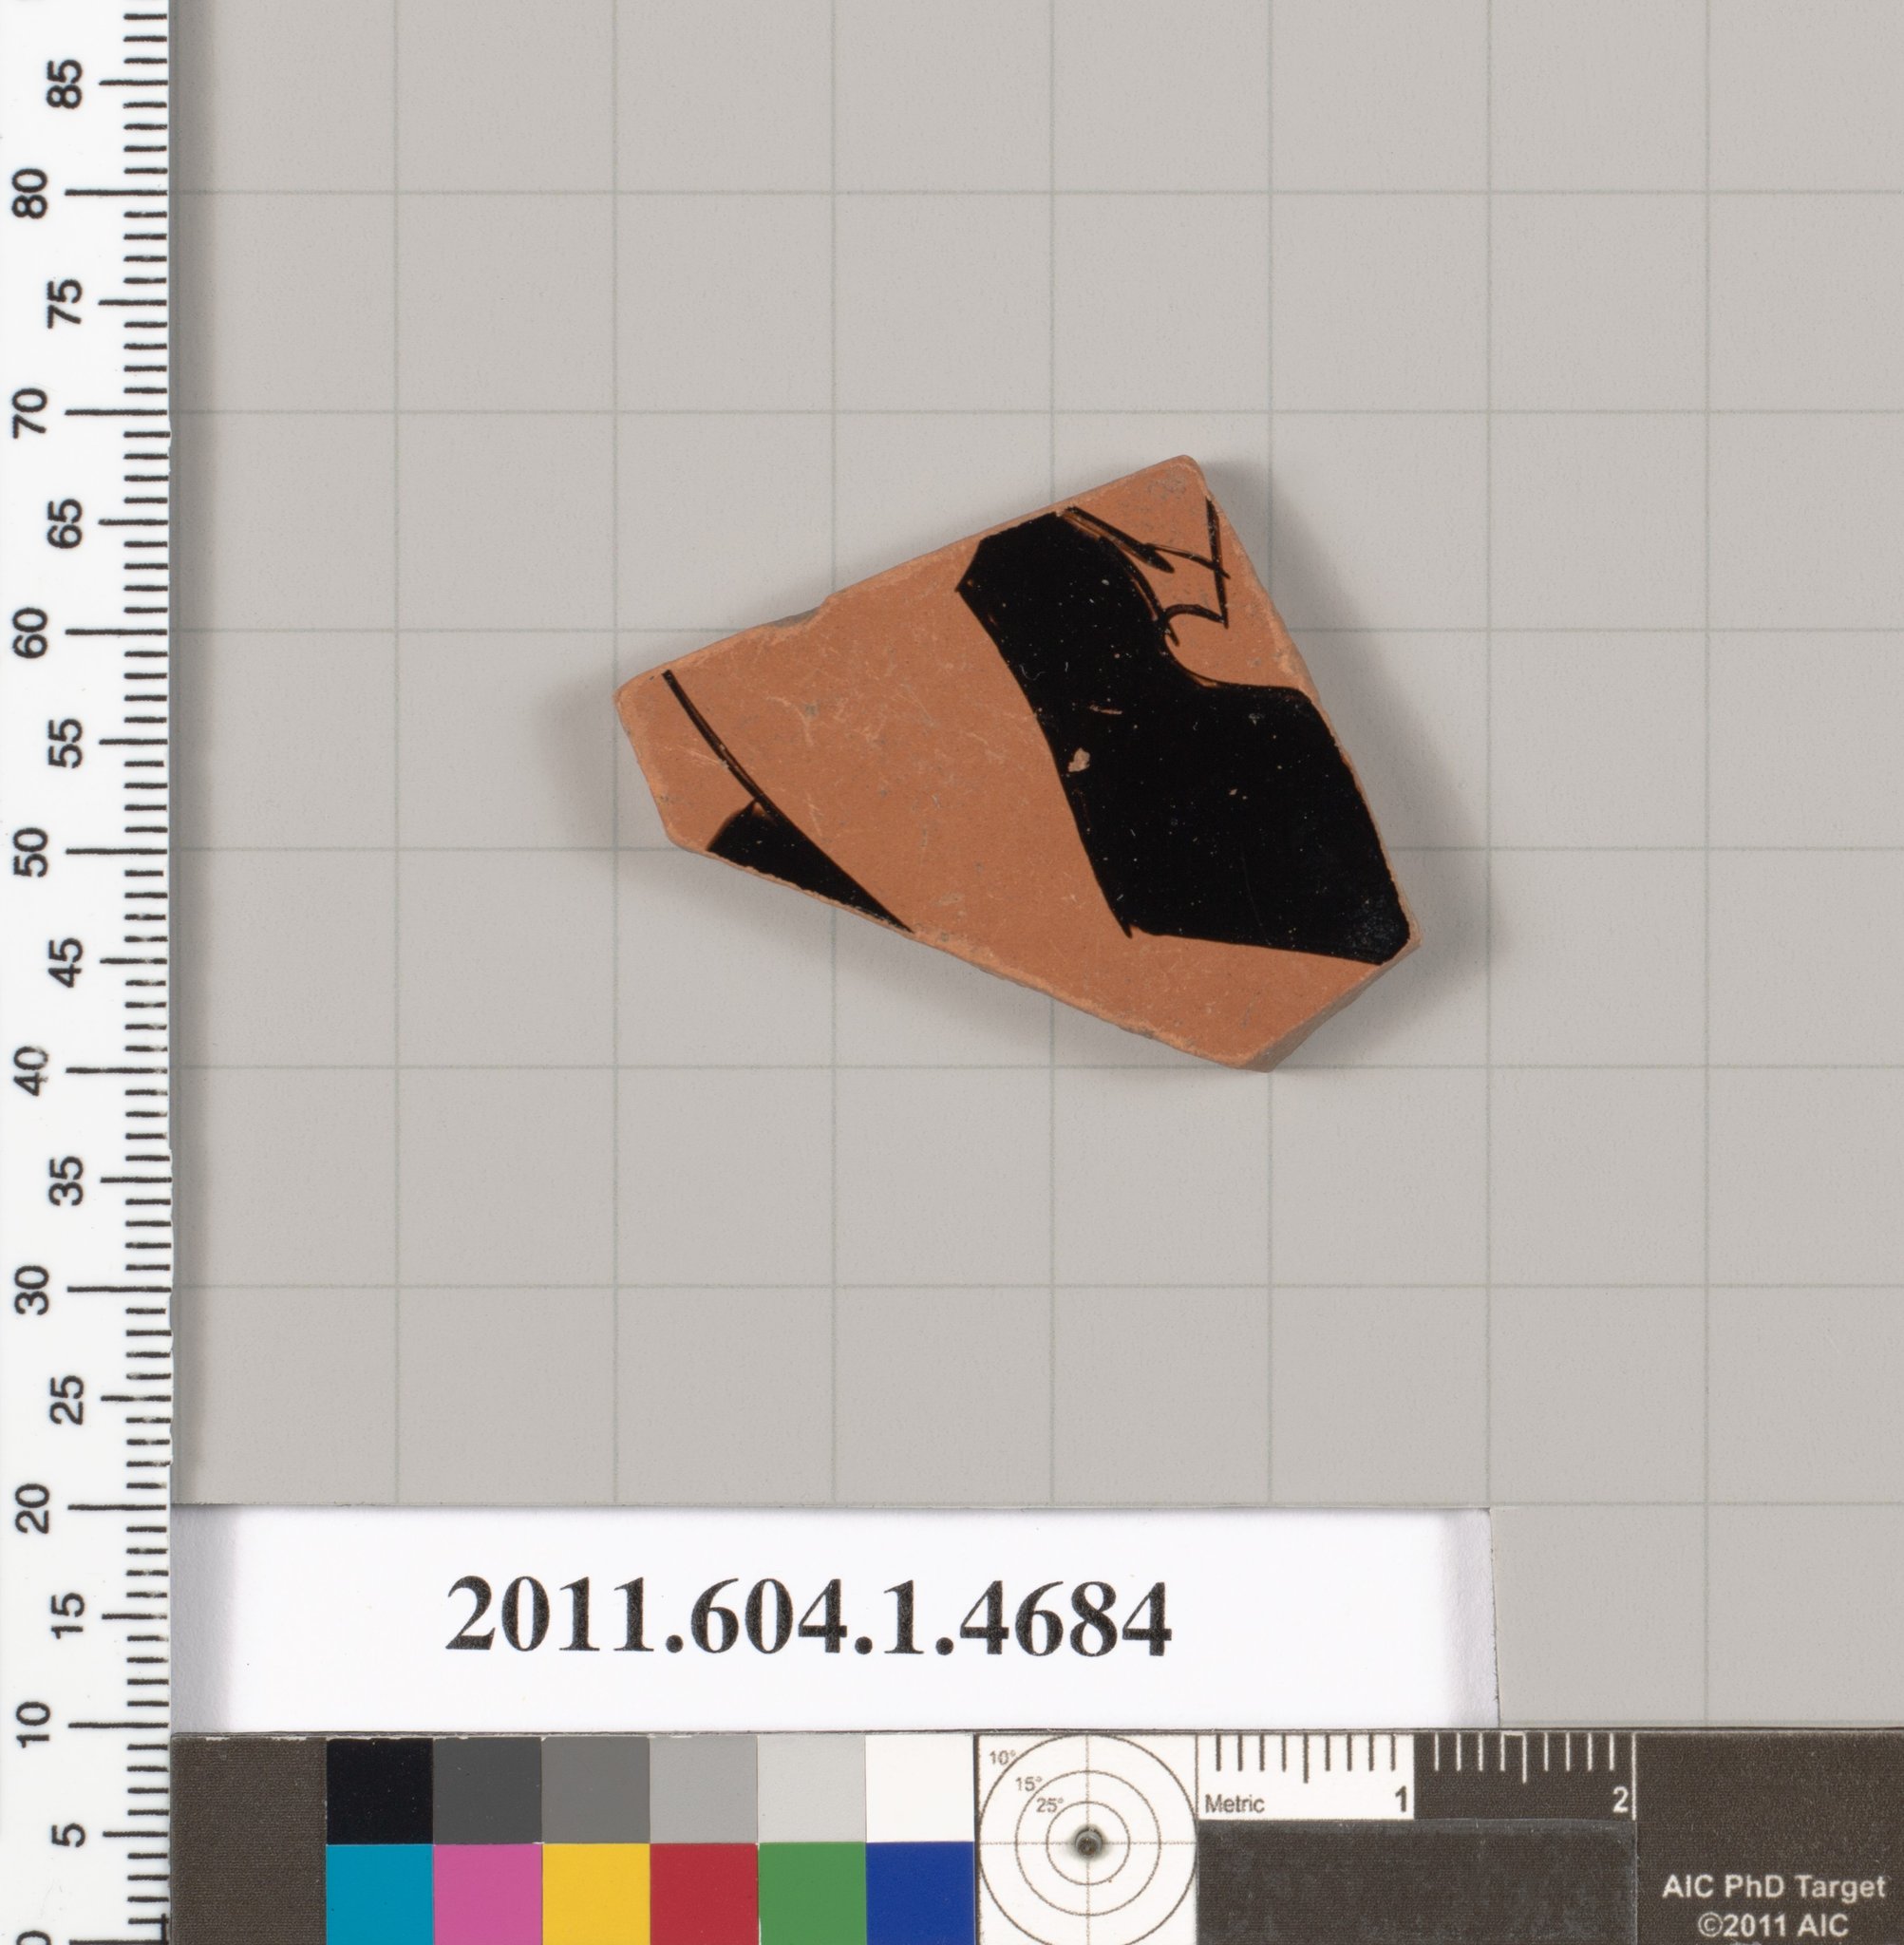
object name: kylix fragment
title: Terracotta fragment of a kylix (drinking cup)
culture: greek, attic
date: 500-480 BCE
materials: terracotta